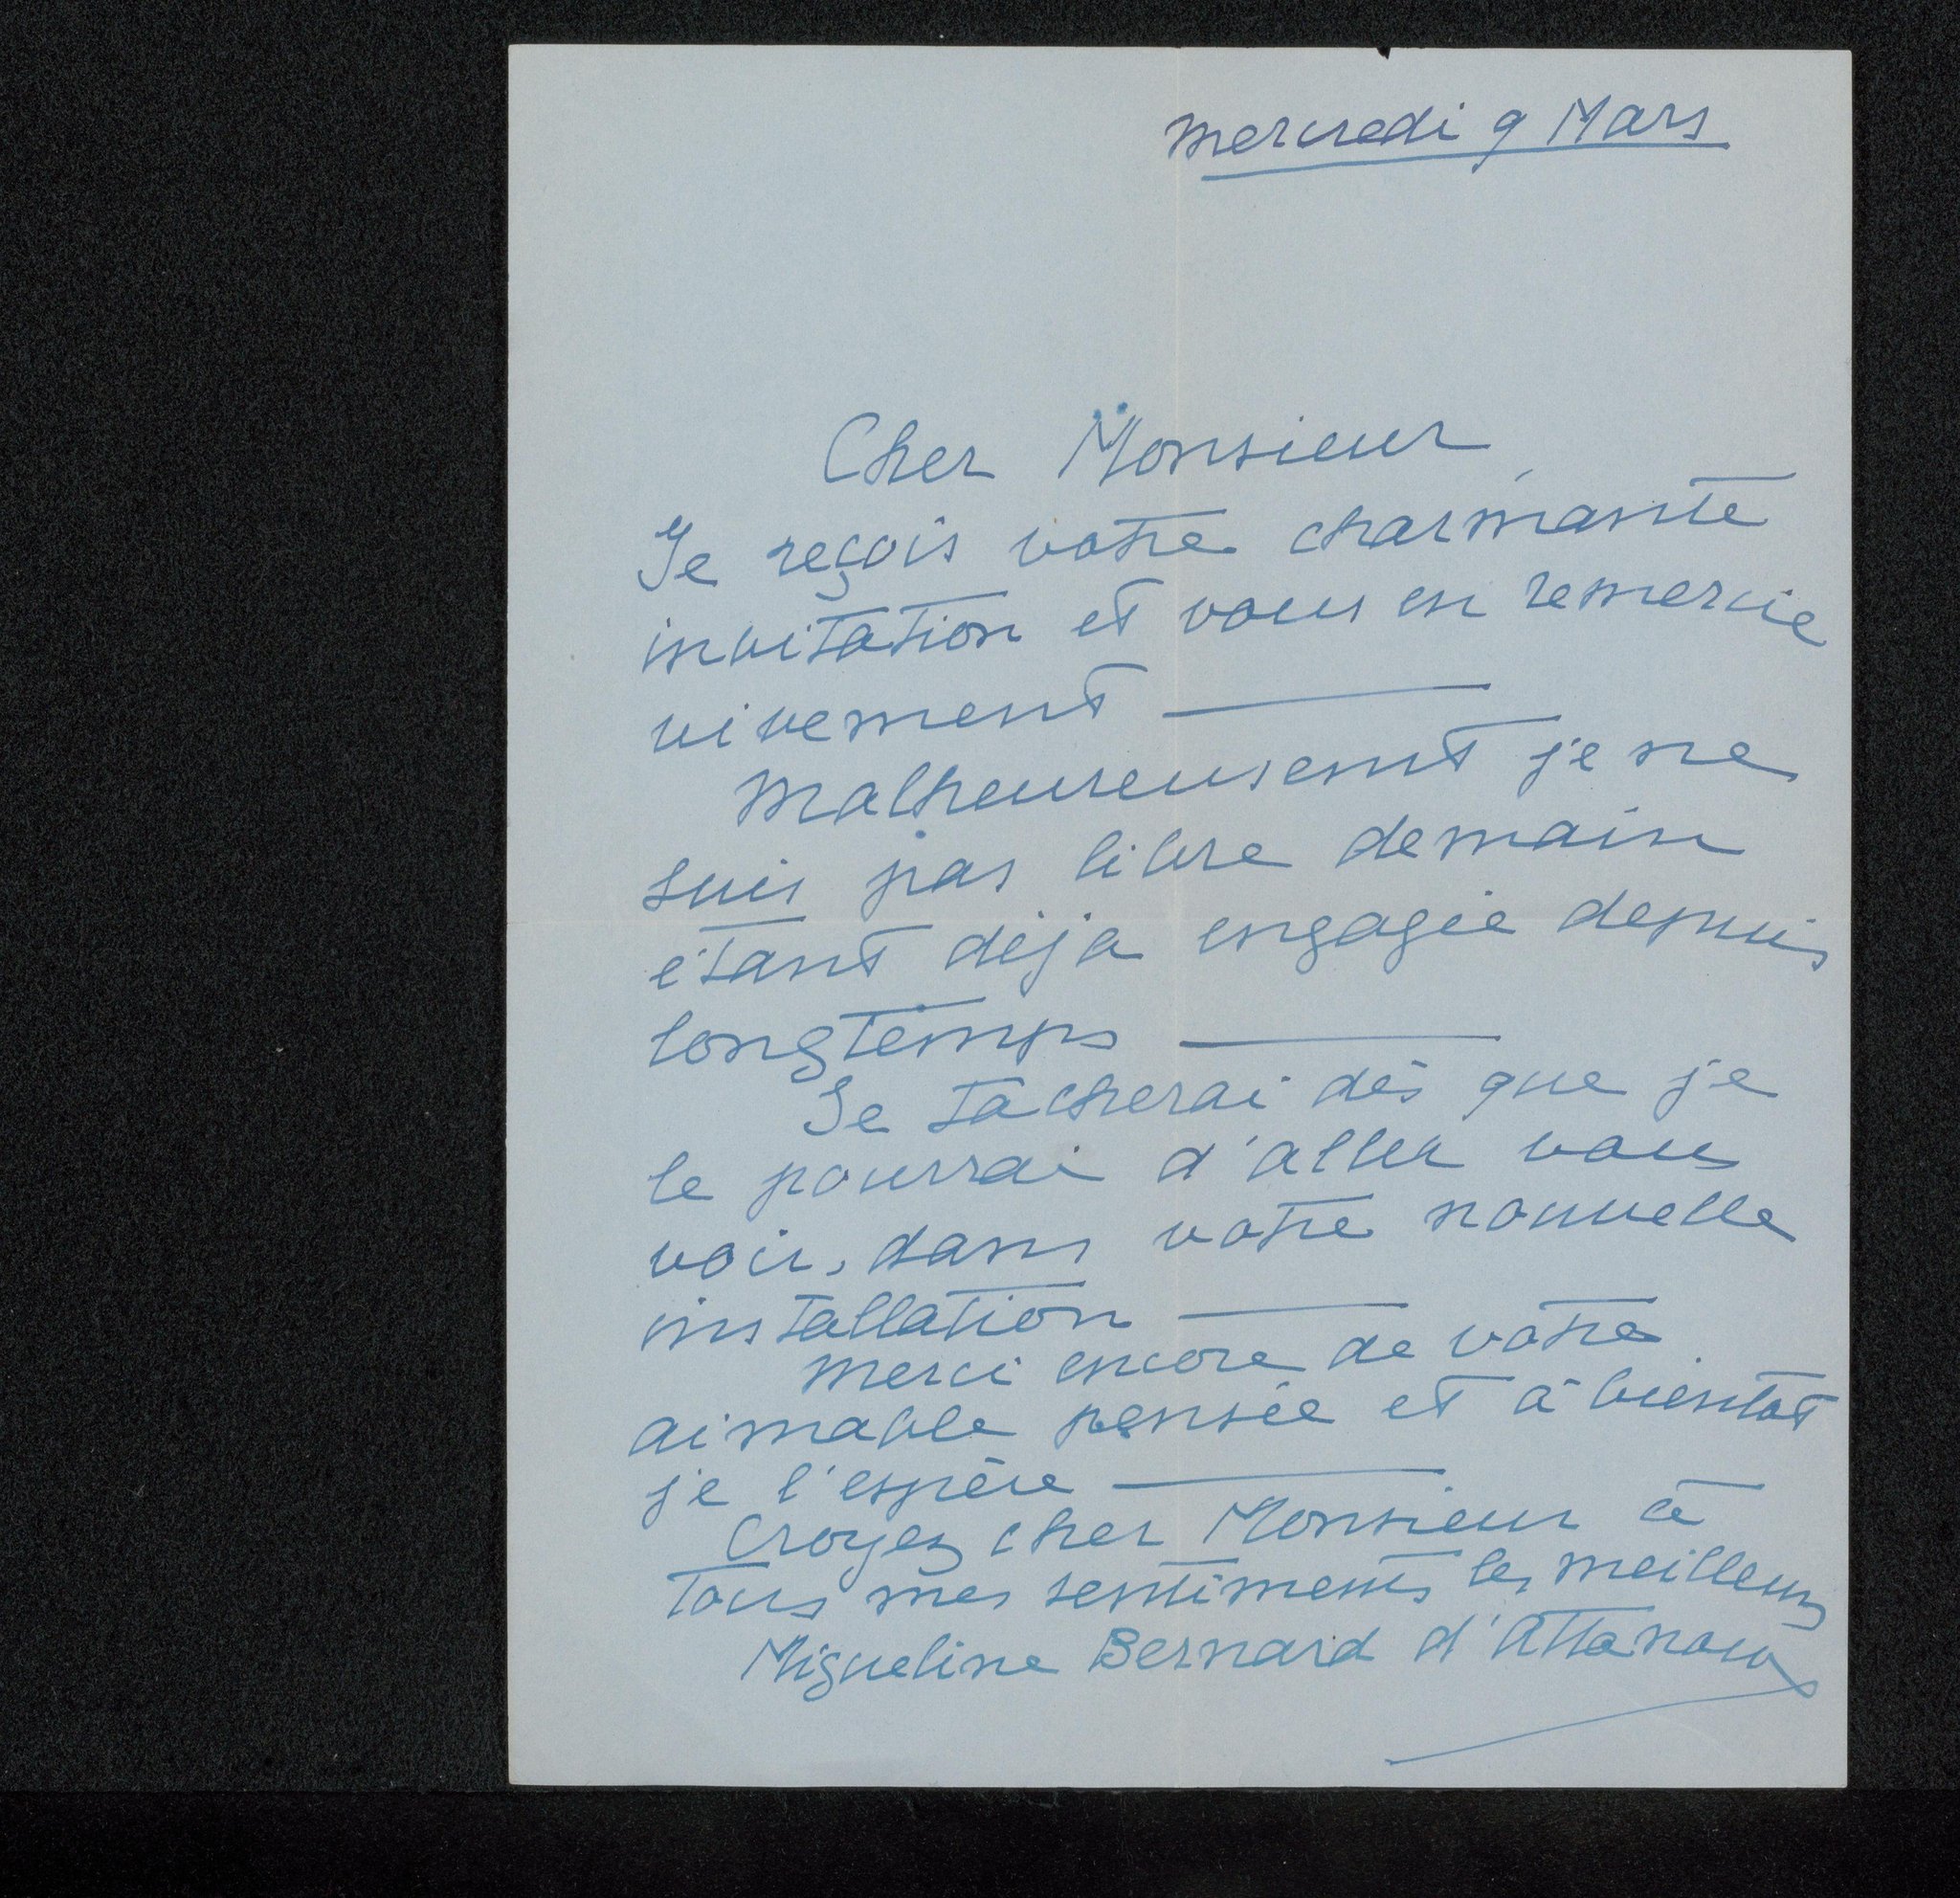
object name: letter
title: Brief aan Philip Zilcken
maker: migueline bernard dattanoux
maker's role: painter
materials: ink, paper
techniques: pen, writing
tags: the hague, draughtsman, philip zilcken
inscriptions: collector's mark: ‘RPK’